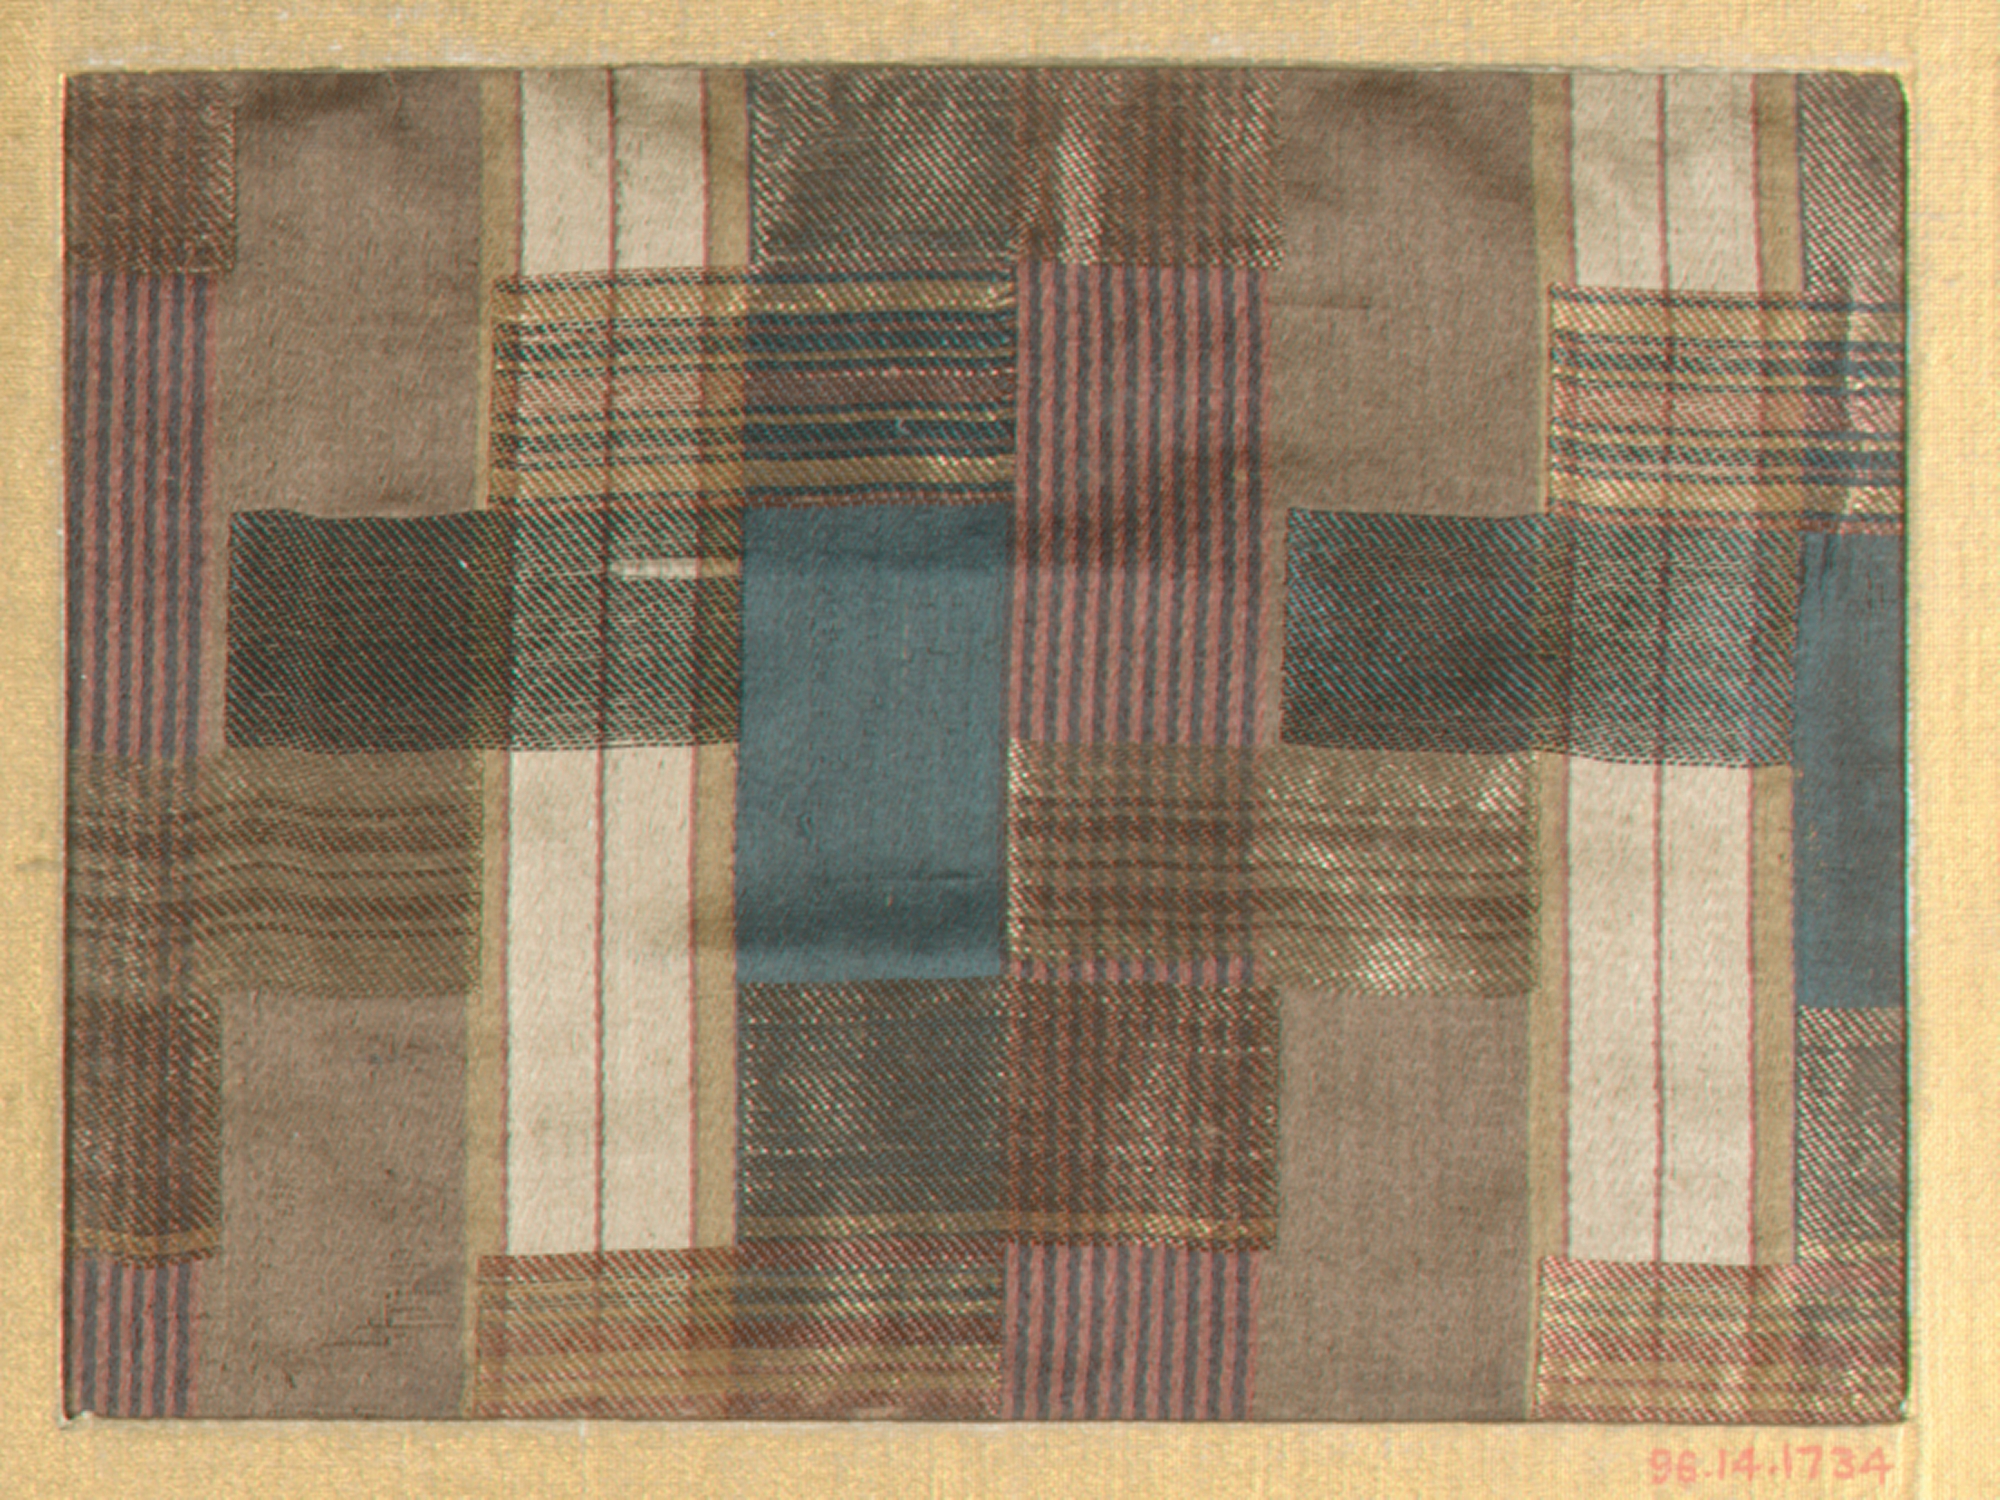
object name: piece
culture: japanese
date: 1701-1900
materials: silk